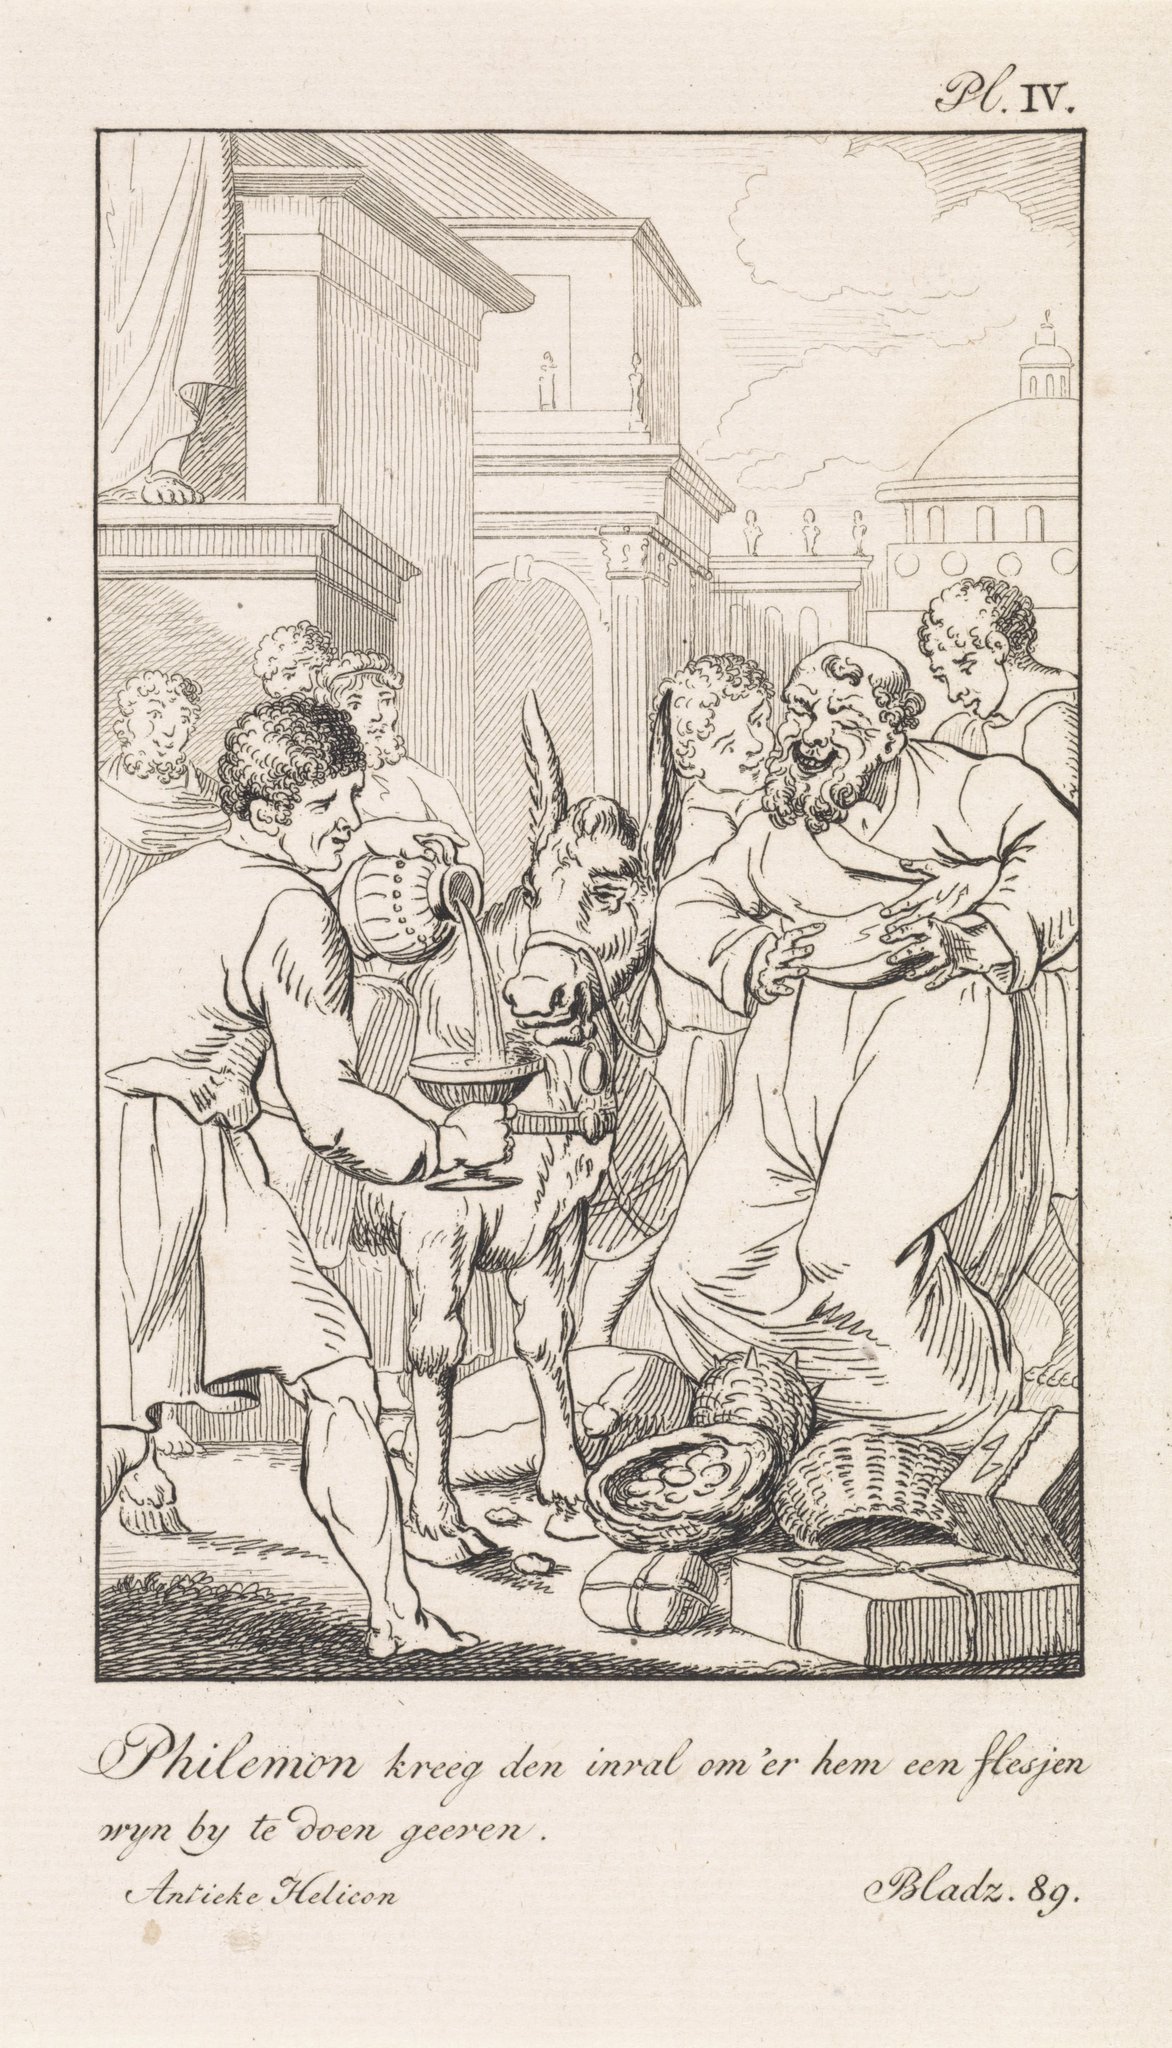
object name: print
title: Figuren bij een ezel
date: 1803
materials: paper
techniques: etching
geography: amsterdam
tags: ass, donkey, caricatures (human types), laughing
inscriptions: collector's mark: Lugt 2228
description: Een man schenkt wijn in een kan om die aan een ezel te drinken te geven. Ernaast een lachende man en meerdere omstanders. Rechtsonder: Bladz. 89. Linksonder: Antieke Helicon. Rechtsboven: Pl. IV.